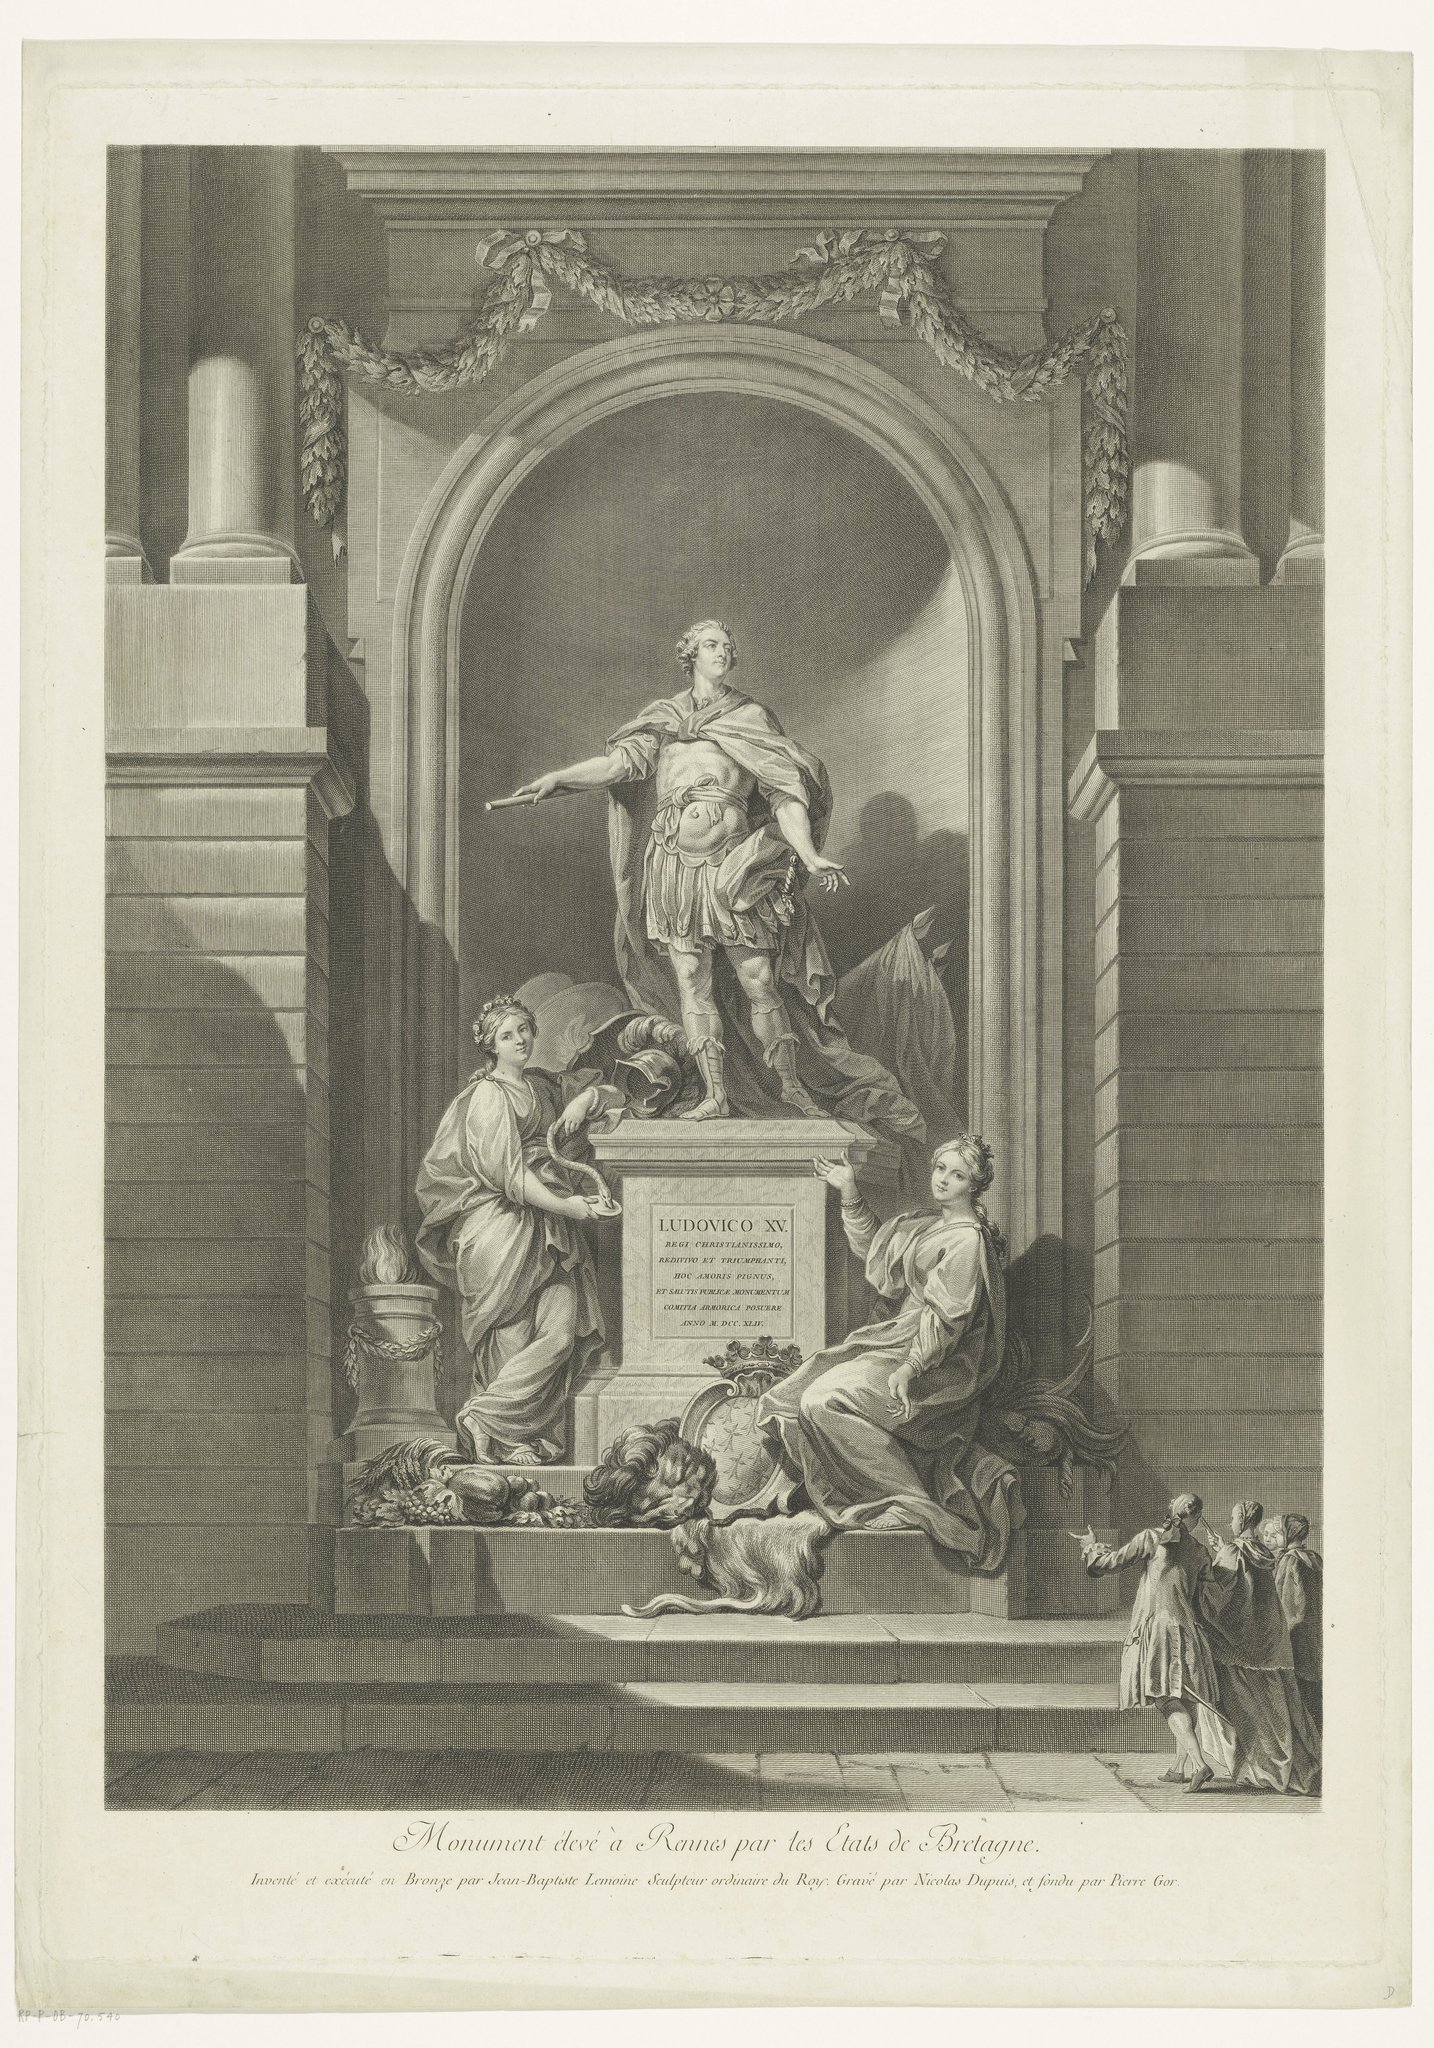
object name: print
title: Monument voor Lodewijk XV, koning van Frankrijk, in Rennes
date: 1754-1771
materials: paper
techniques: engraving, etching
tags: lodewijk xiv (koning van frankrijk), historical persons, monument, statue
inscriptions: collector's mark: Lugt 2165